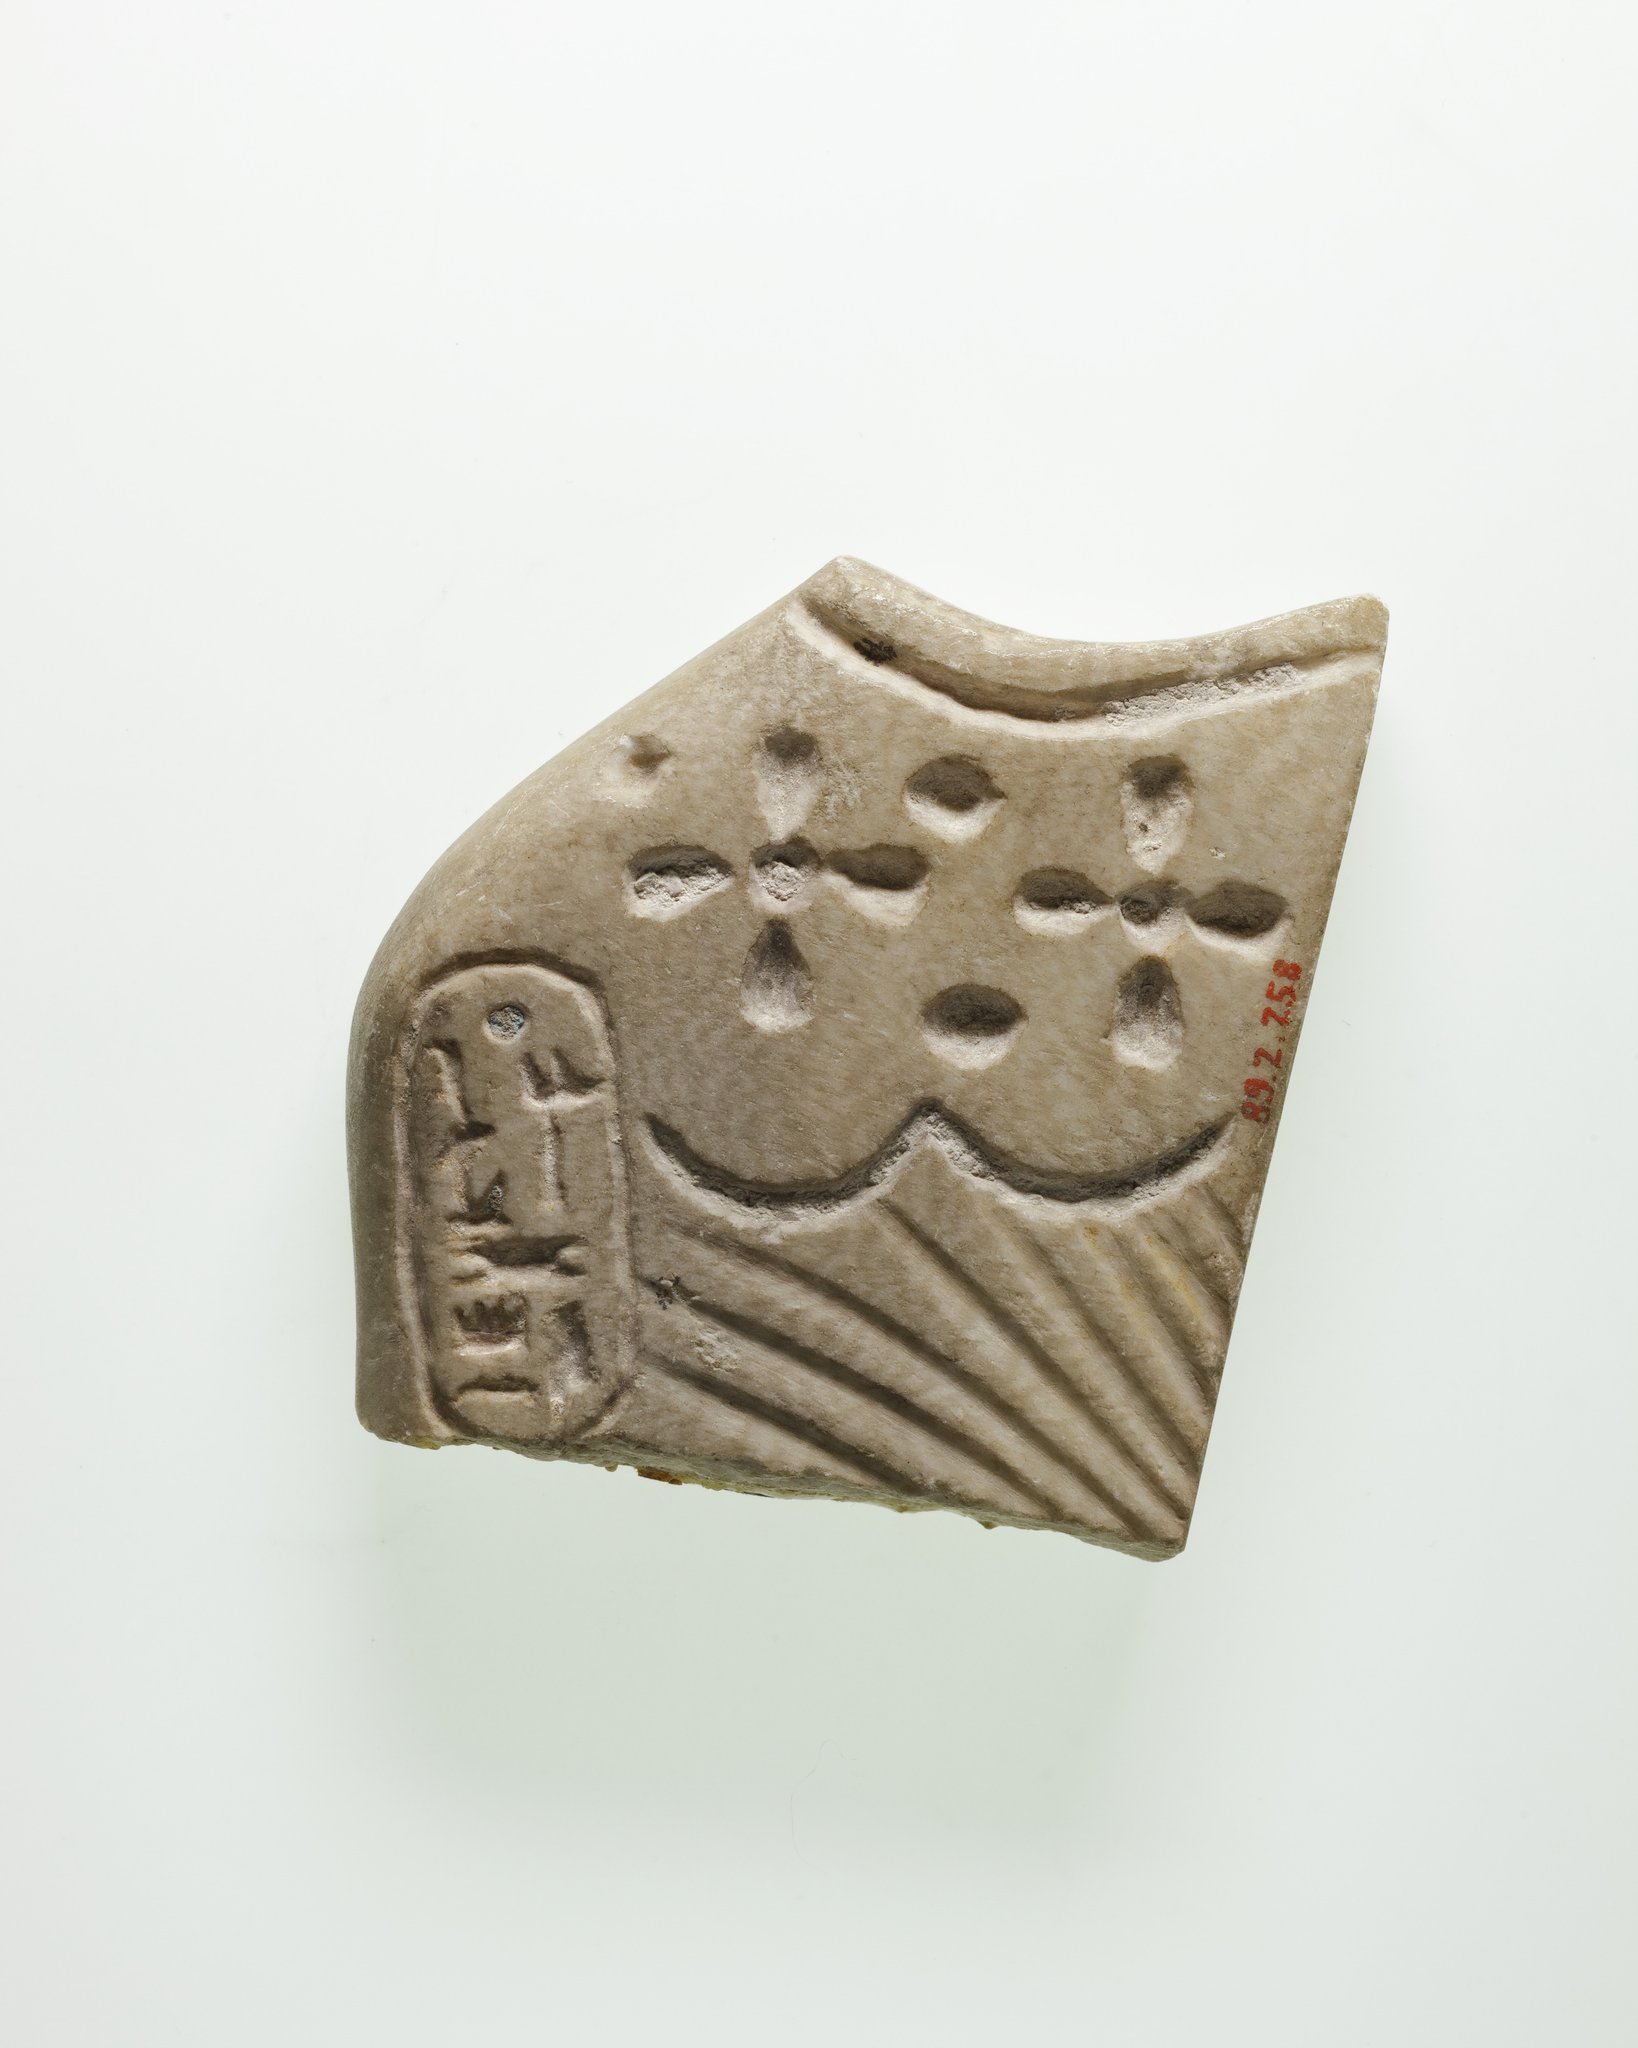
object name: tile fragment, shoulder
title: Shoulder fragment of a figural tile, with the cartouche of Ramesses III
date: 1184-1153 BCE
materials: stone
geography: egypt